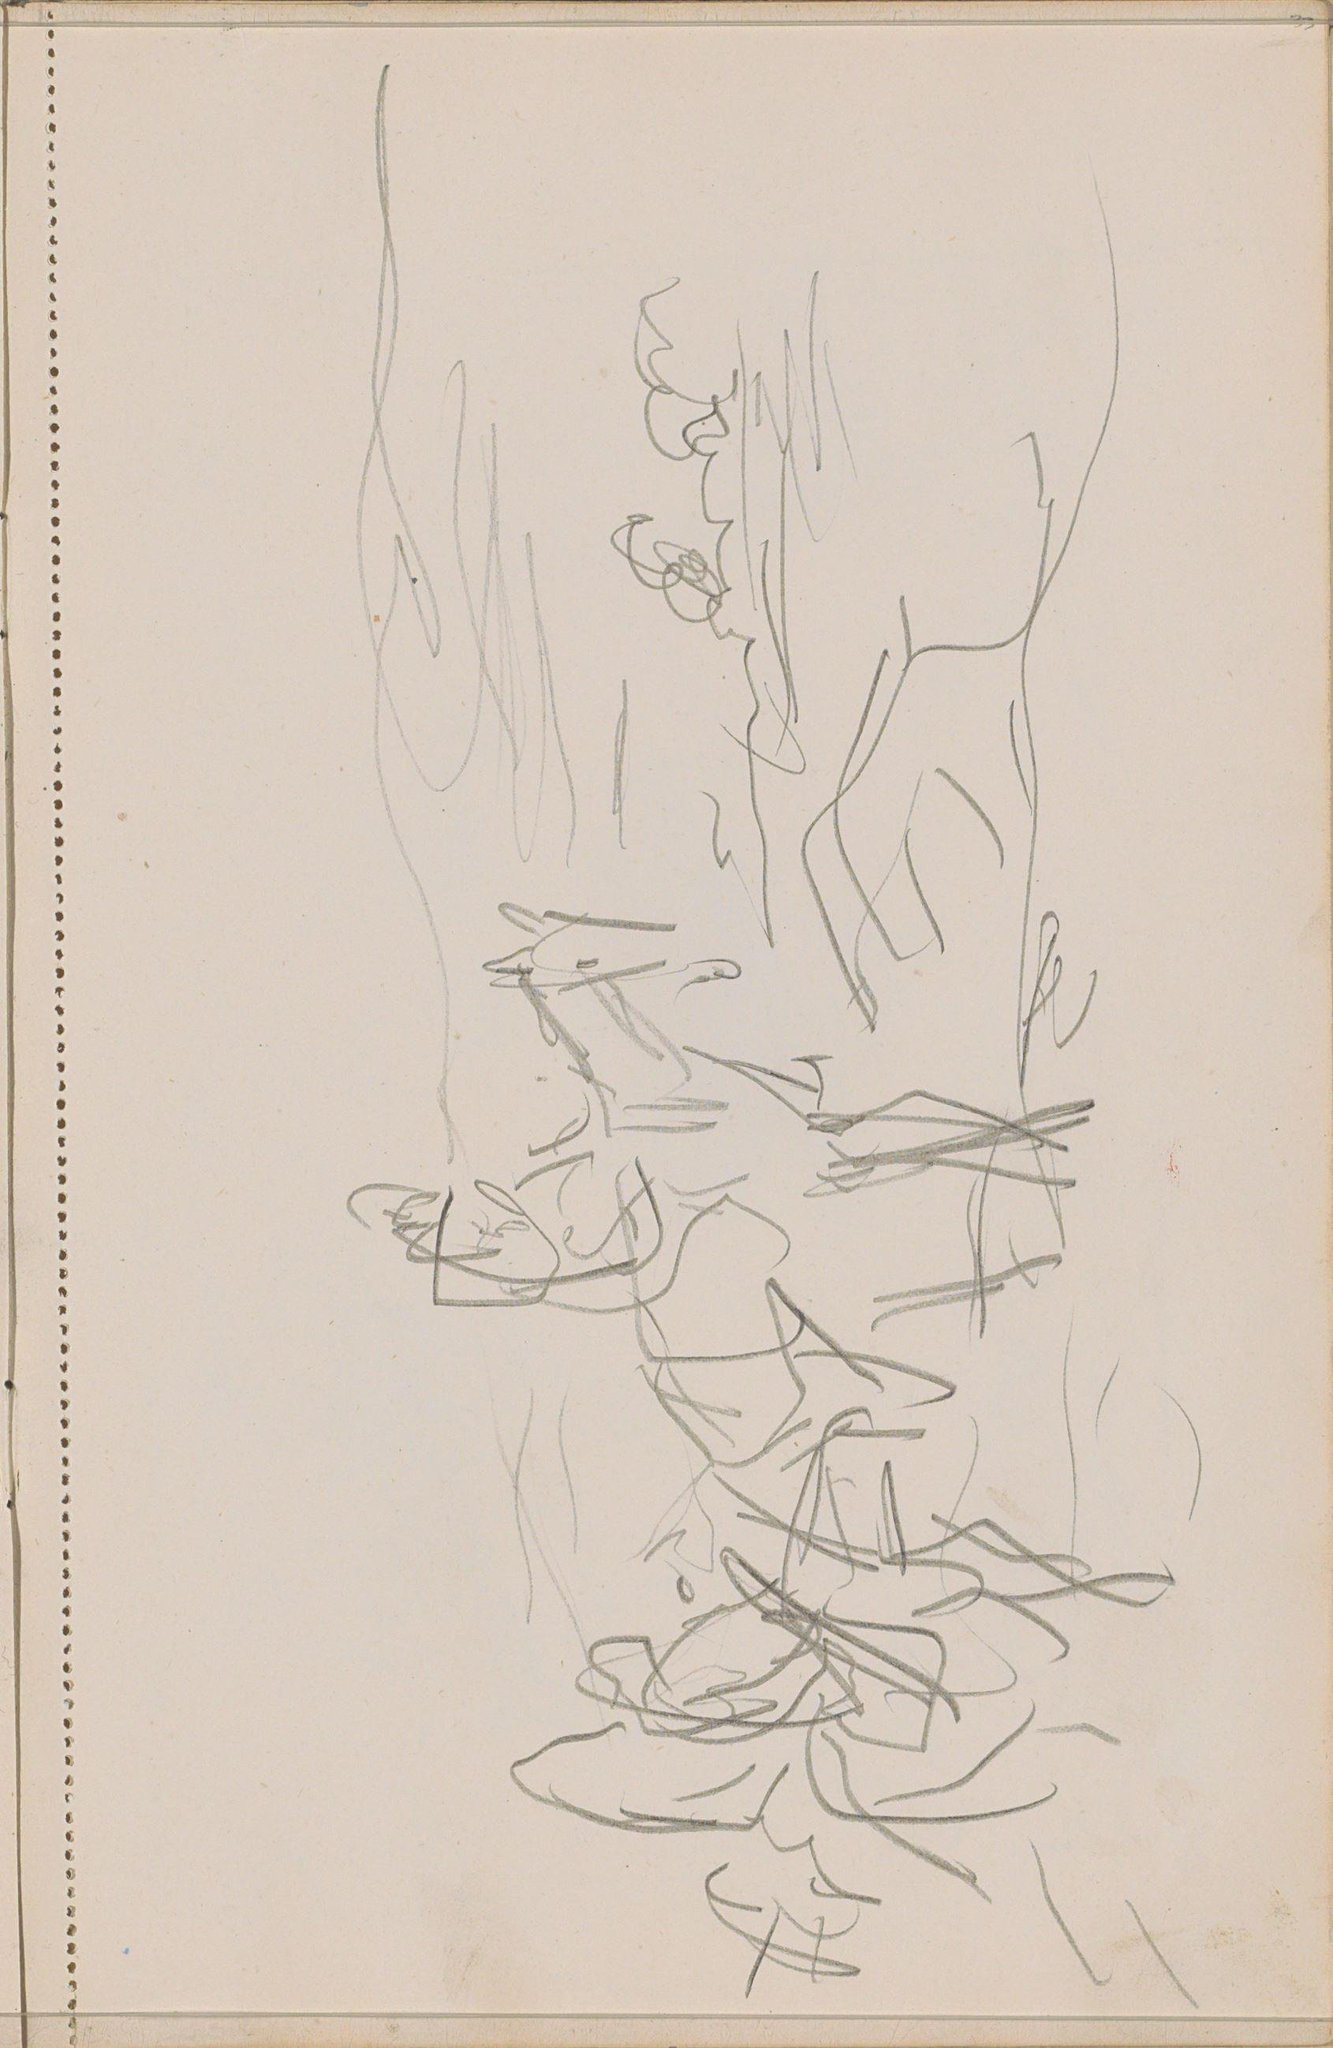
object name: sketchbook leaf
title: Ruiters in een heuvellandschap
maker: marius bauer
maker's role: draughtsman, print maker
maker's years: 1867-1932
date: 1923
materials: paper, pencil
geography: morocco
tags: riding a horse, ass, or mule; rider, horseman, low hill country, landscapes (+ landscape with figures, staffage)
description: Pagina 33 uit een schetsboek met 66 bladen.